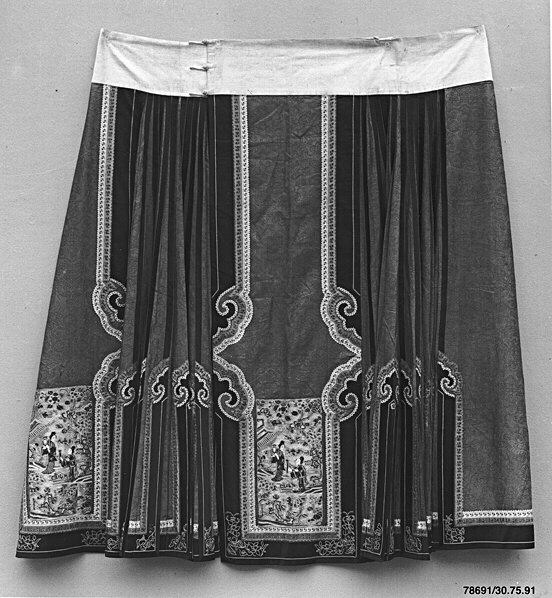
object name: skirt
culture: chinese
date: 1701-1800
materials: gold, silk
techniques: damask, embroidery, stitching